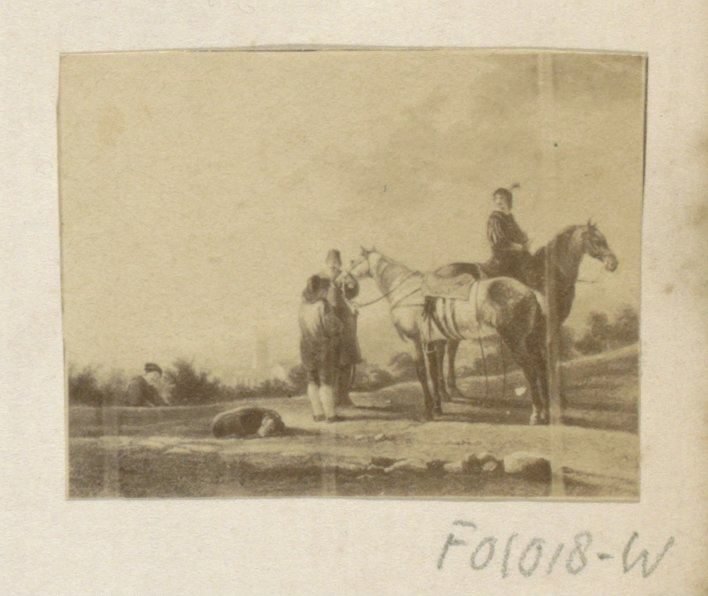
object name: reproduction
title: Fotoreproductie van (vermoedelijk) een schilderij met ruiters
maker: Anonymous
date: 1860-1870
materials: paper, photographic support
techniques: albumen print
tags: riding a horse, ass, or mule; rider, horseman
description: Onderdeel van Engels familiealbum met foto's van personen, reizen, cricket en kunstwerken.